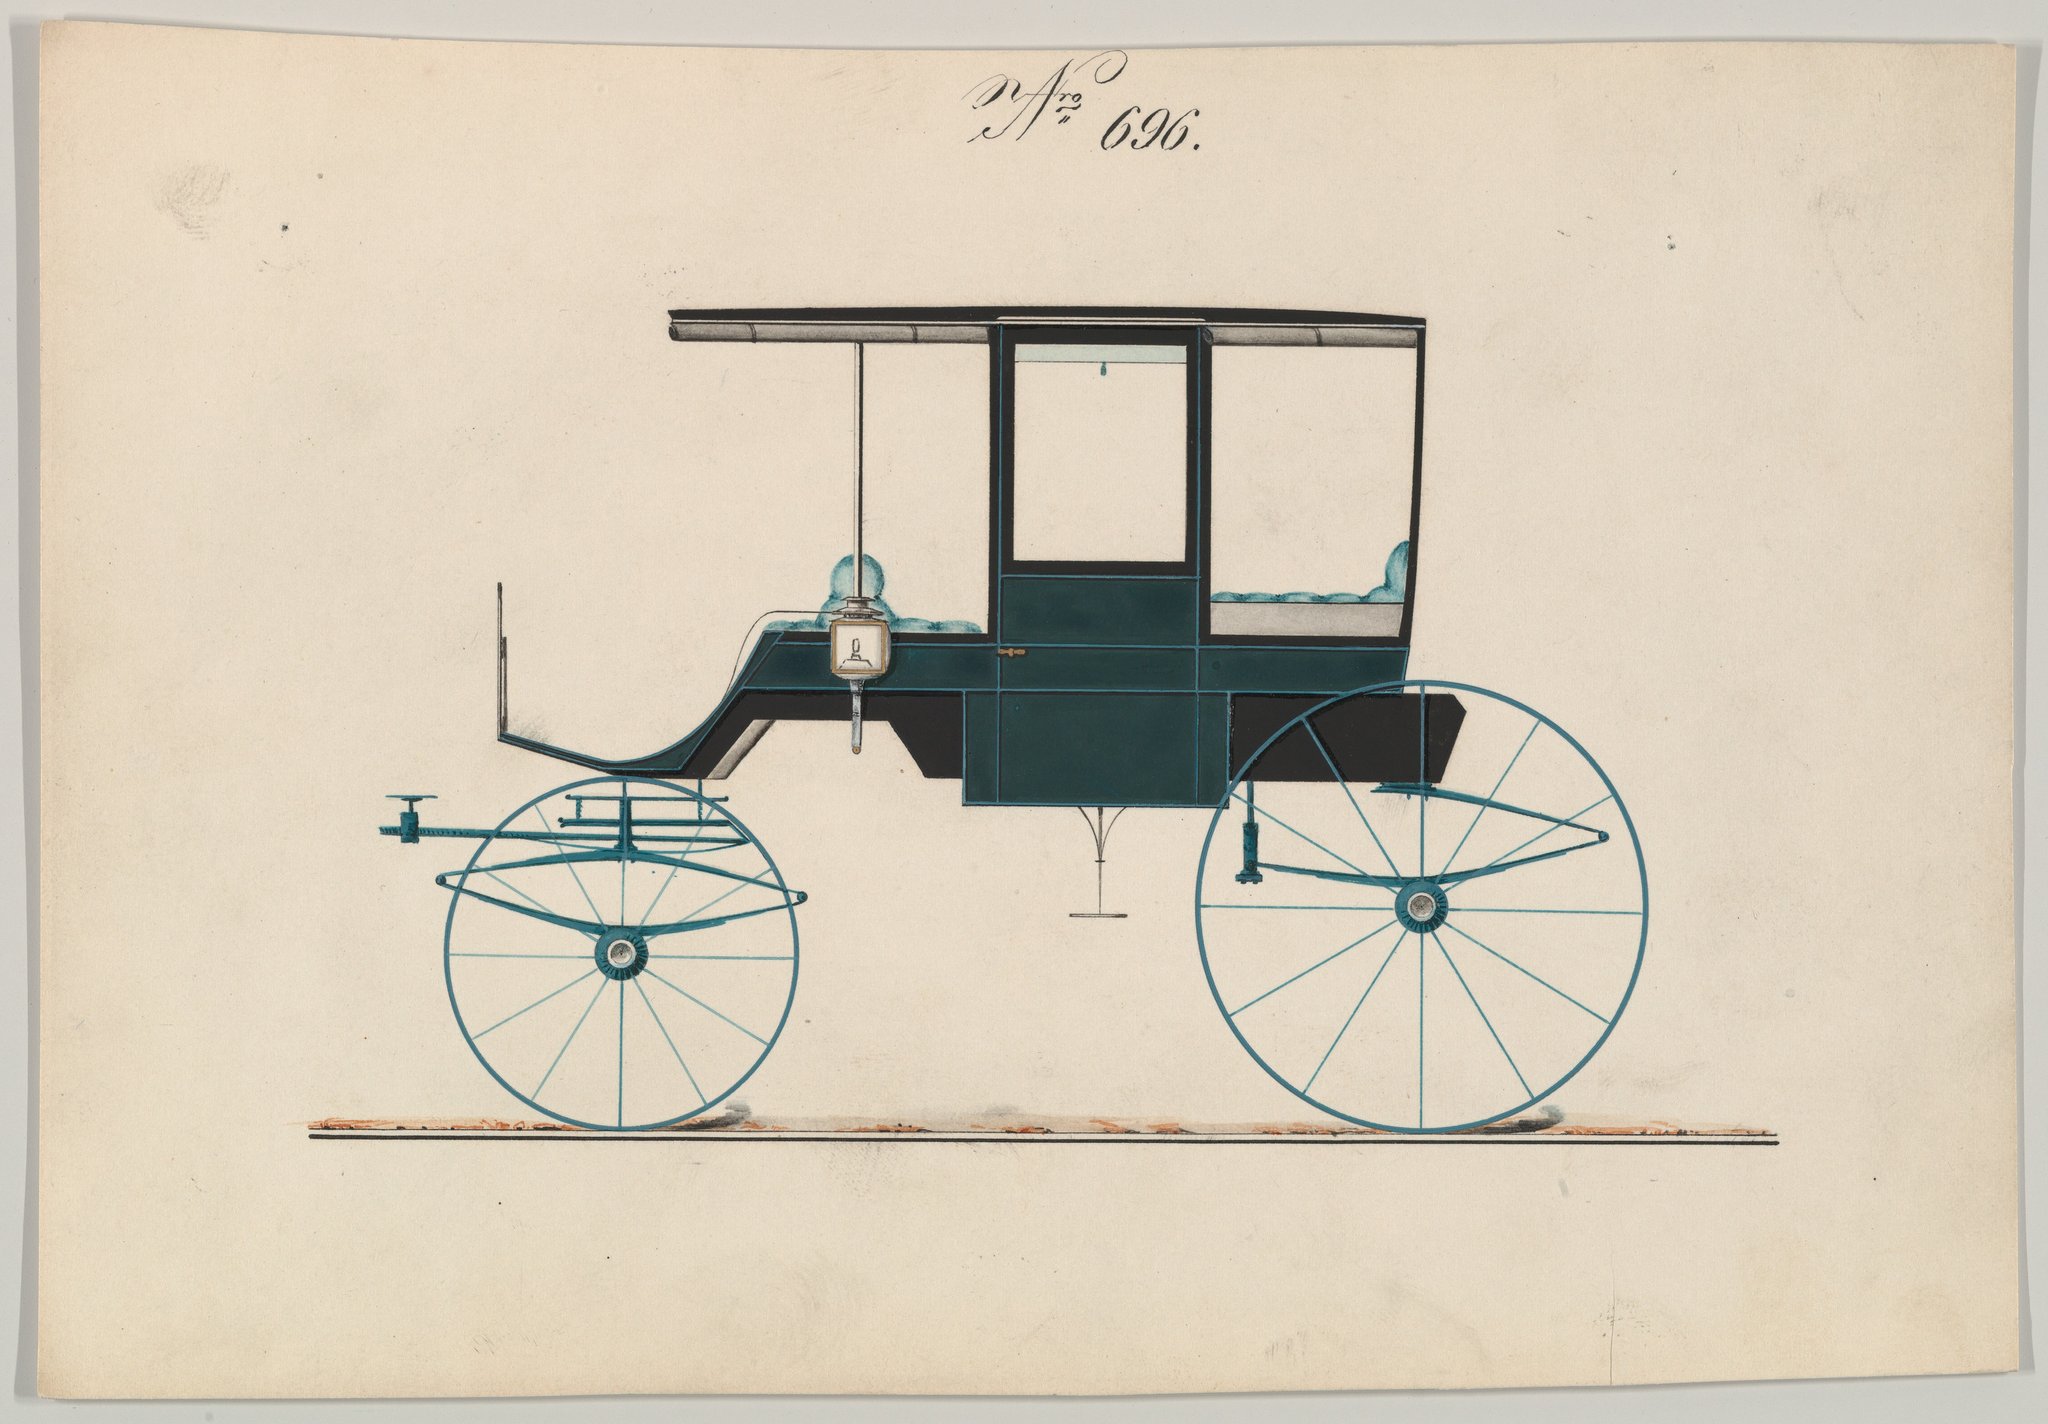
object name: drawing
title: Rockaway #696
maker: brewster & co.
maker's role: manufacturer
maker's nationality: american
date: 1865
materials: gouache, gum arabic, ink, watercolor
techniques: pen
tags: carriages